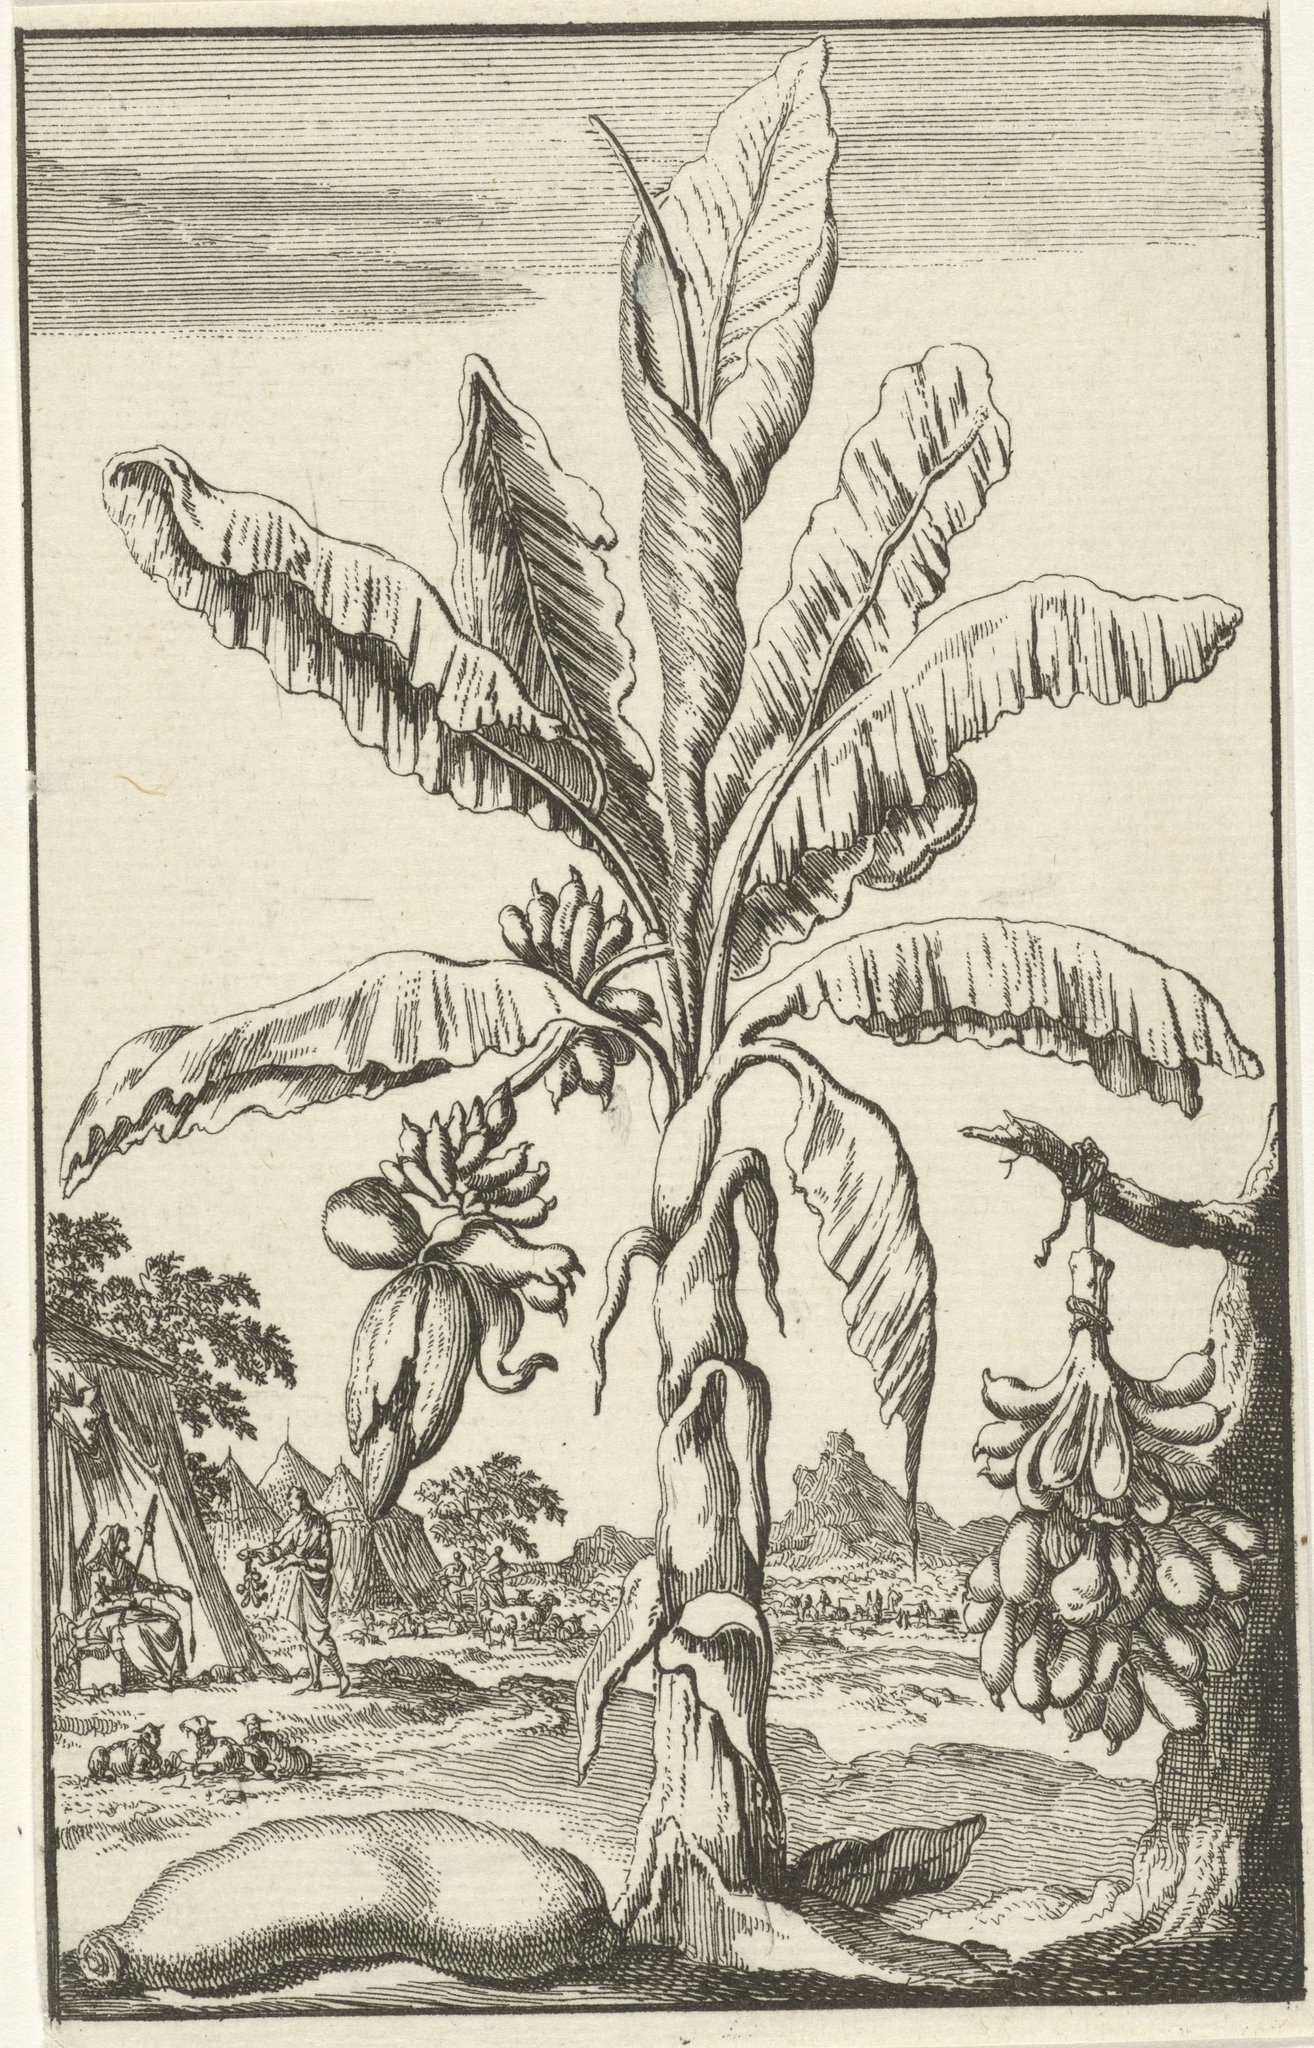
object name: print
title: Boom met liefdesappels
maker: Anonymous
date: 1683-1762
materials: paper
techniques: etching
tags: reuben brings mandrakes to his mother leah, mandrake, 'mandragora'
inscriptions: collector's mark: Lugt 2228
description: Originele illustratie opgenomen in: Cunaeus, Petrus. De republyk der Hebreen, of gemeenebest der joden, 3 delen. Amsterdam: Wilhelmus Goeree, 1683, dl. 2, p. 490.